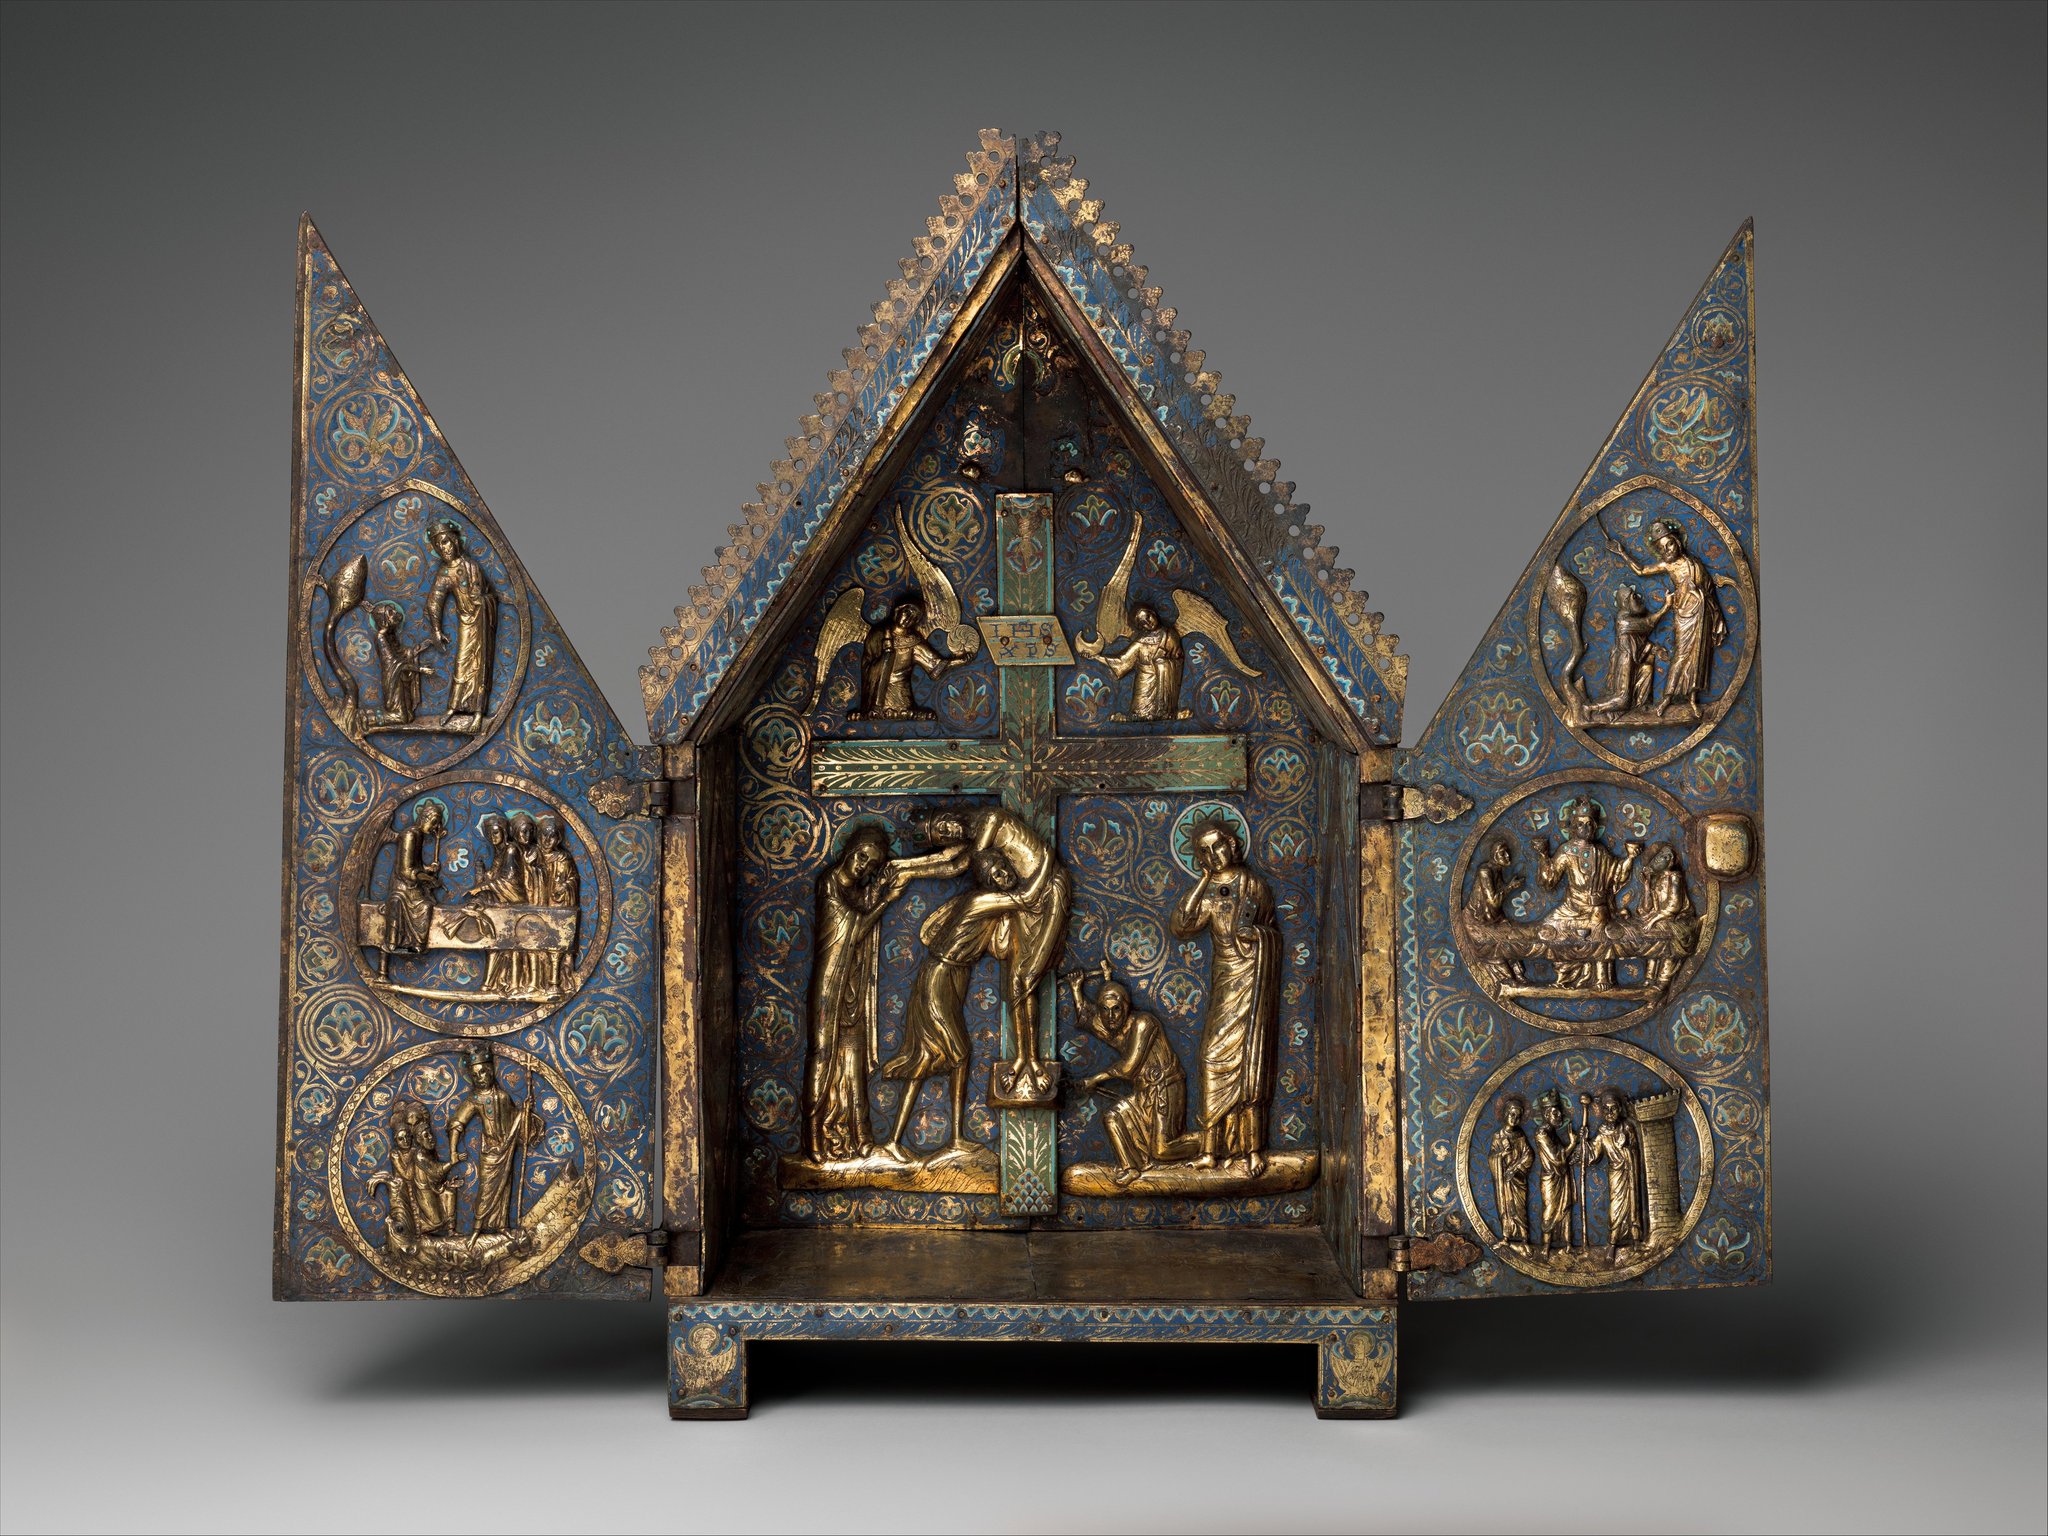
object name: tabernacle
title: Tabernacle of Cherves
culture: french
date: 1220-1230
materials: copper, enamel, gilt, wood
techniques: enamel, chasing, engraving, repoussé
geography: france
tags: angels,christ,virgin mary,crucifixion,descent from the cross